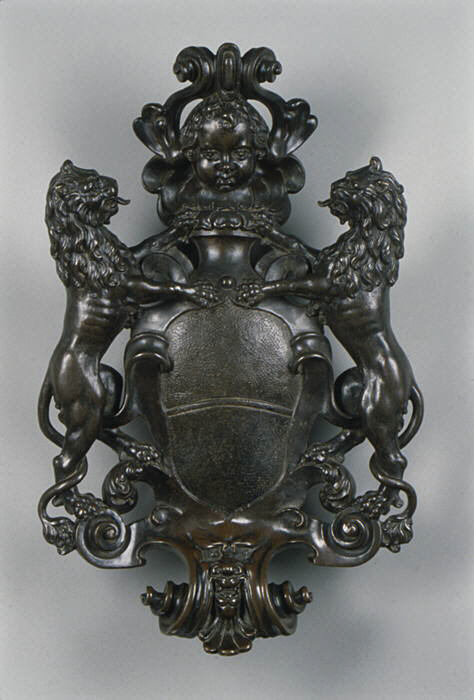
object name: door knocker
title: Door knocker (one of a pair)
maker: hubert gerhard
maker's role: artist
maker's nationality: netherlandish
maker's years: 1540-1621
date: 1600-1625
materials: bronze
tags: faces,lions